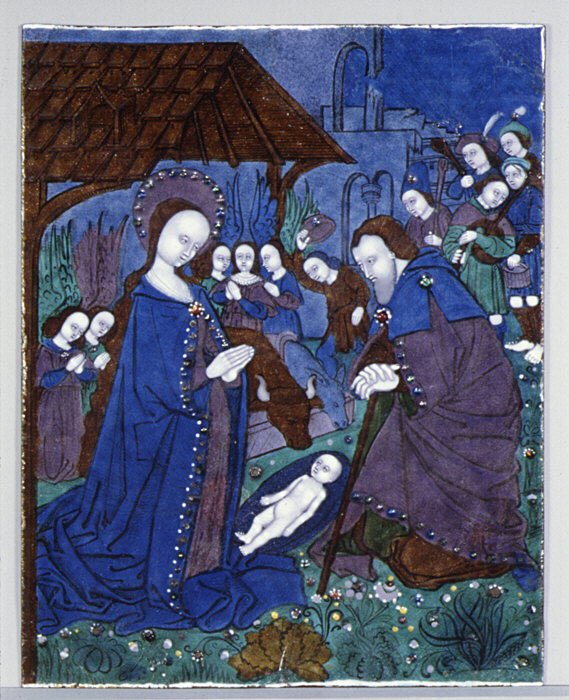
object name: panel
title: The Adoration of the Shepherds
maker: workshop of the master of the high foreheads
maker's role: artist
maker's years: -1600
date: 1501-1533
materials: copper, enamel, gilt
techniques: painting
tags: adoration of the shepherds